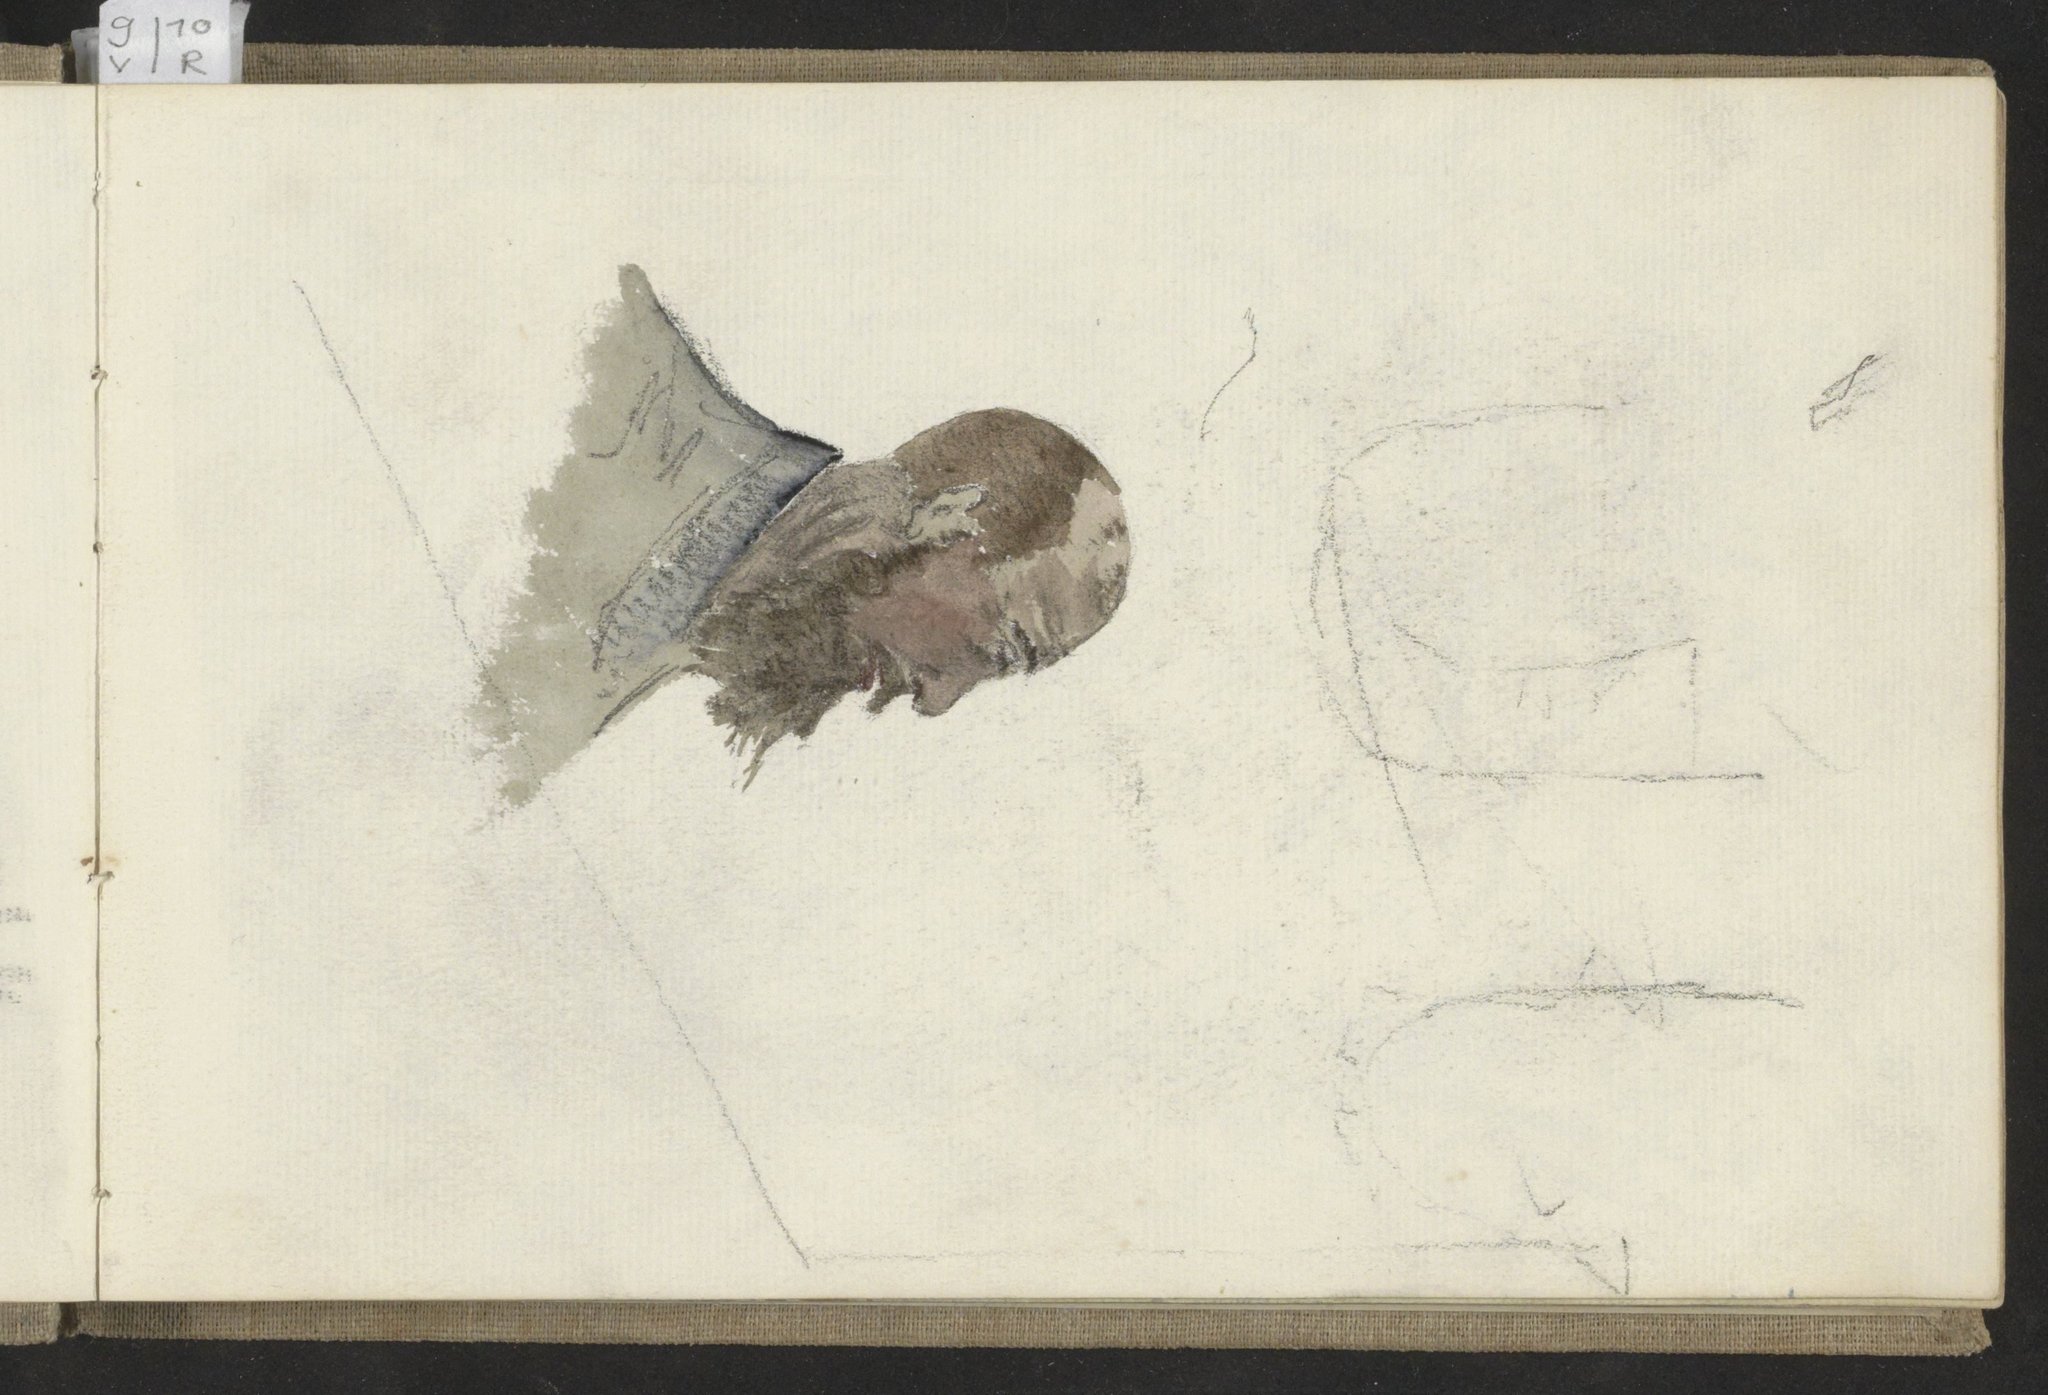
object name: sketchbook leaf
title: Portret van een man met een baard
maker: jonkheer johannes ludovicus paulus bosch van drakestein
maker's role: draughtsman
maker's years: 1865-1929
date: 1896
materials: paper, pencil, watercolor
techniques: brush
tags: head (human) (+ right side visible; right - (r. hand, r. foot, etc.)), beard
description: Blad 5 recto uit een schetsboek met 58 bladen.